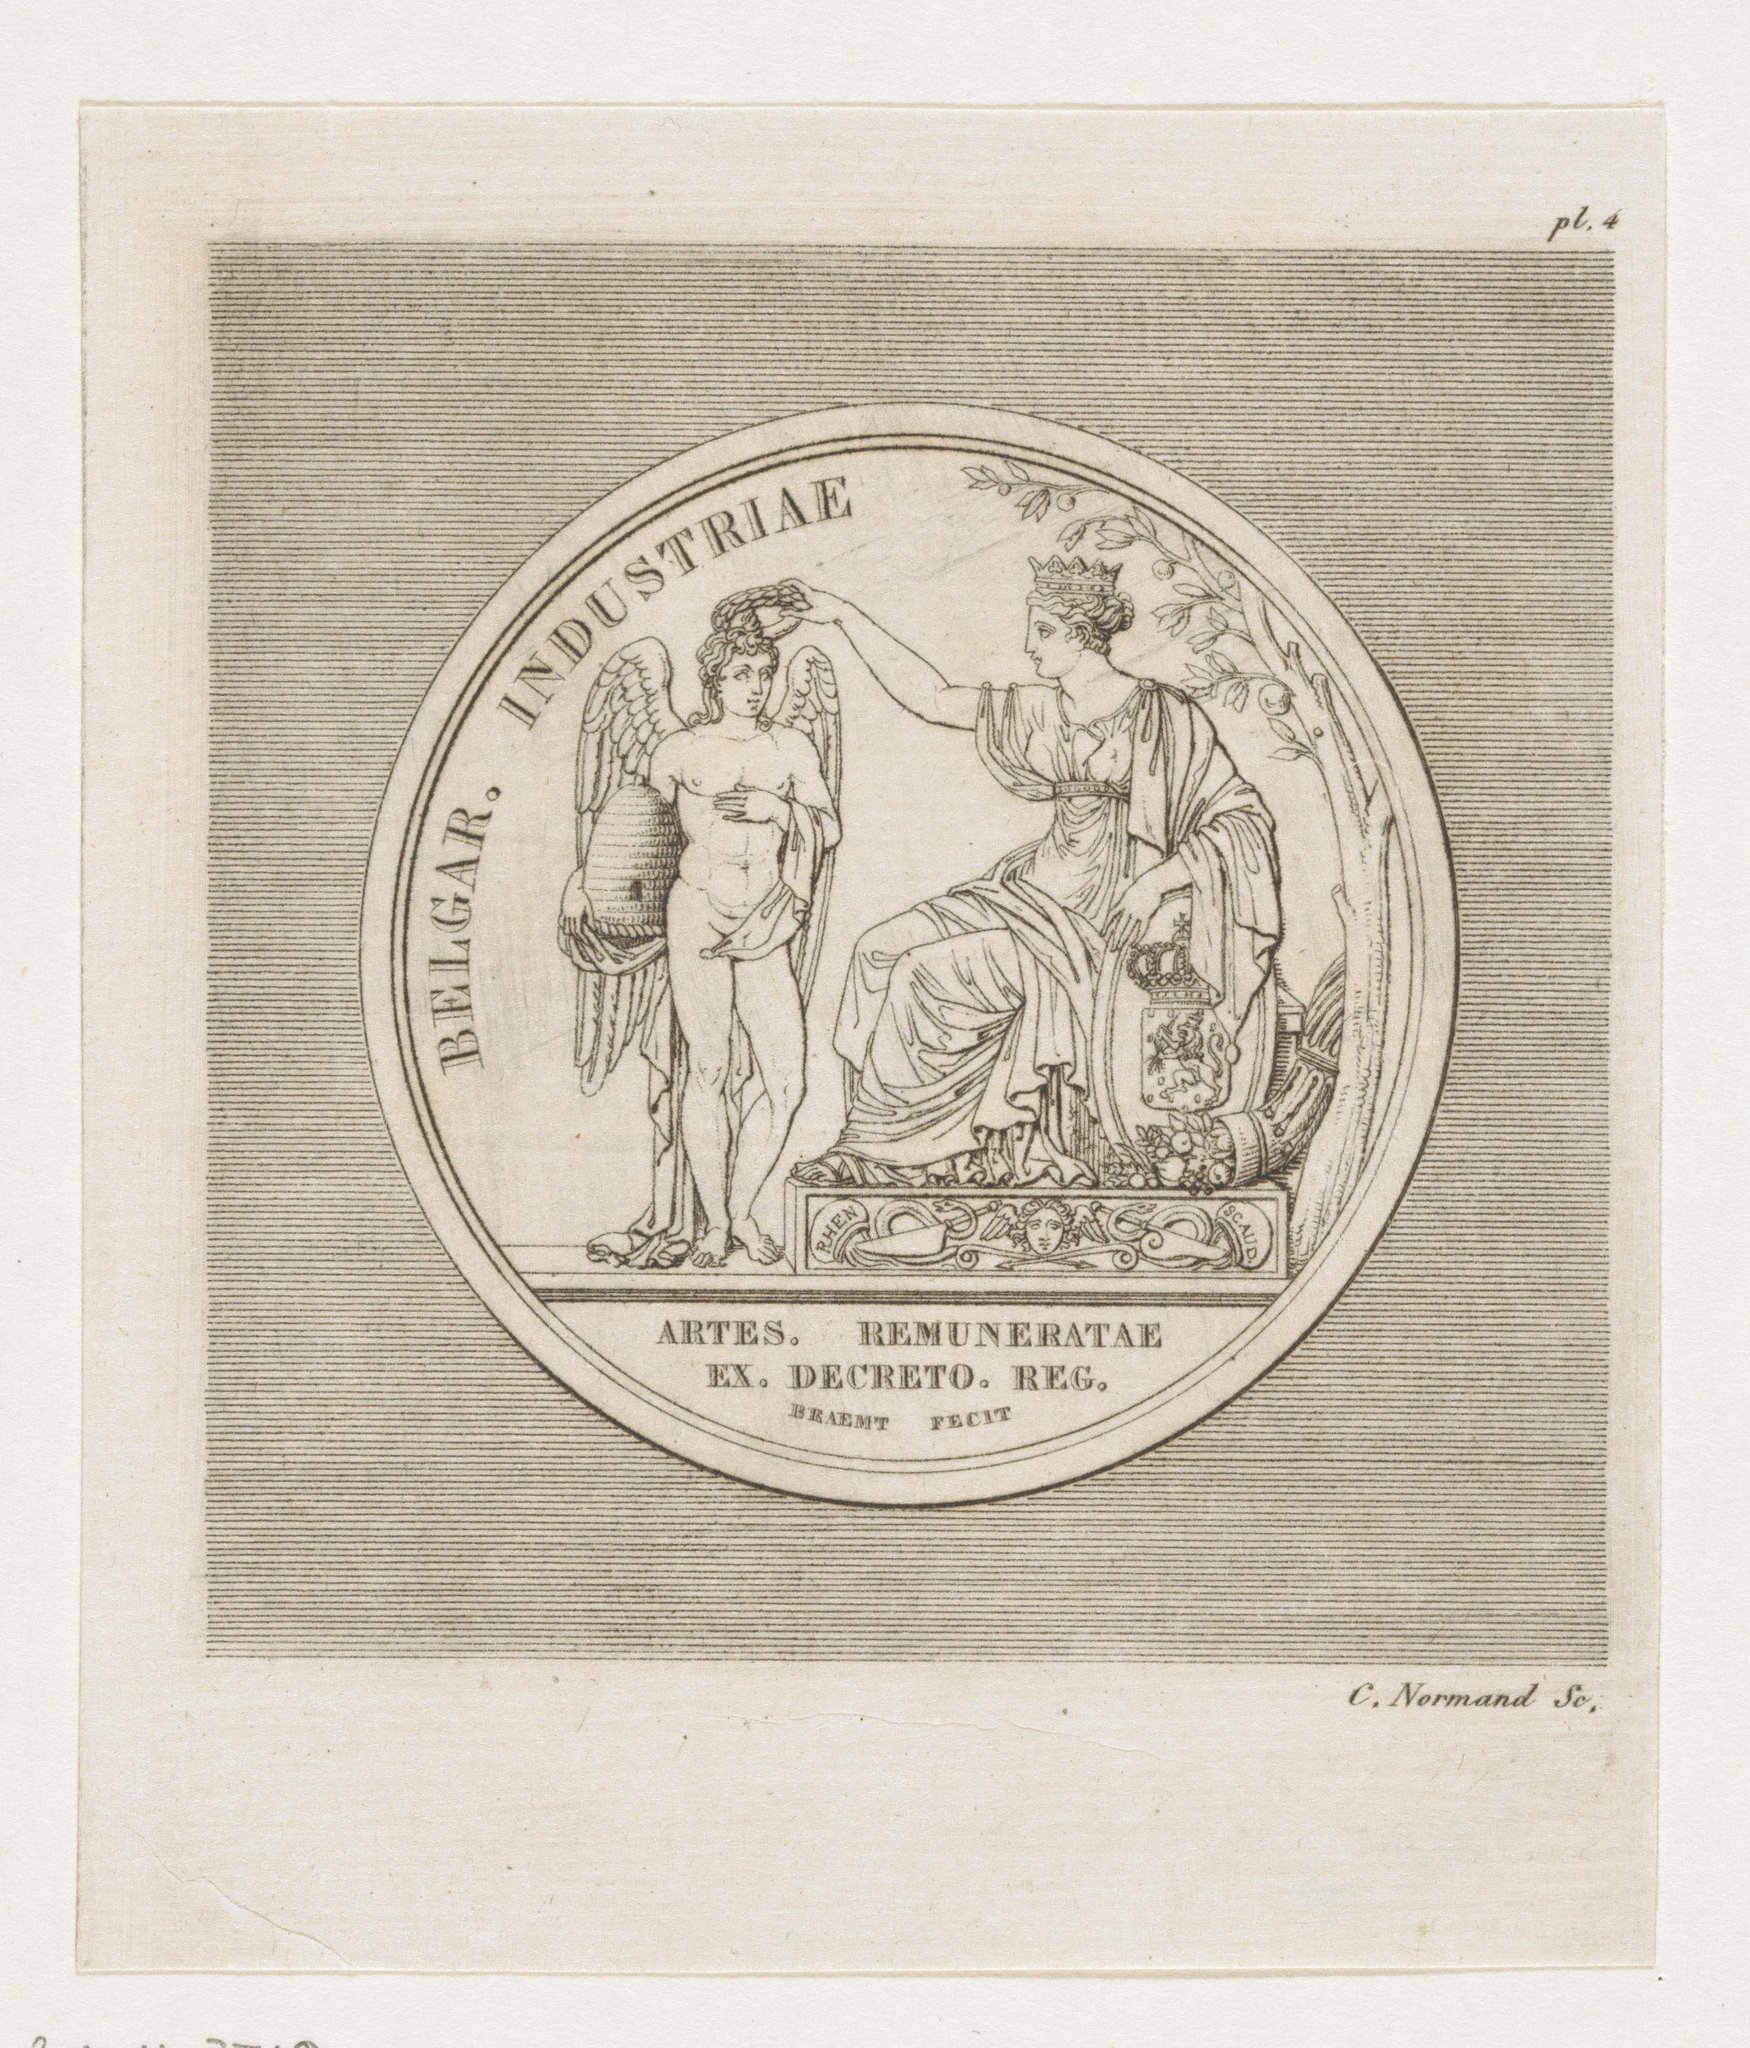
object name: print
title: Medaille als prijs uitgereikt op de Tentoonstelling Nationale Nijverheid, 1825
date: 1825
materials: paper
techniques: etching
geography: netherlands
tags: personifications of countries, nations, states, districts, etc., industriousness, assiduity; 'assiduità', 'industria', 'zelo' (ripa), medal (considered as a piece of sculpture, regardless of its specific function), haarlem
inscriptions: collector's mark: Lugt 2228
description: Prijspenning uitgereikt op de Tentoonstelling Nationale Nijverheid, Haarlem 1825. In de voorstelling kroont de Nederlandse Maagd de Nijverheid. Rechtsboven gemerkt 'pl. 4'.